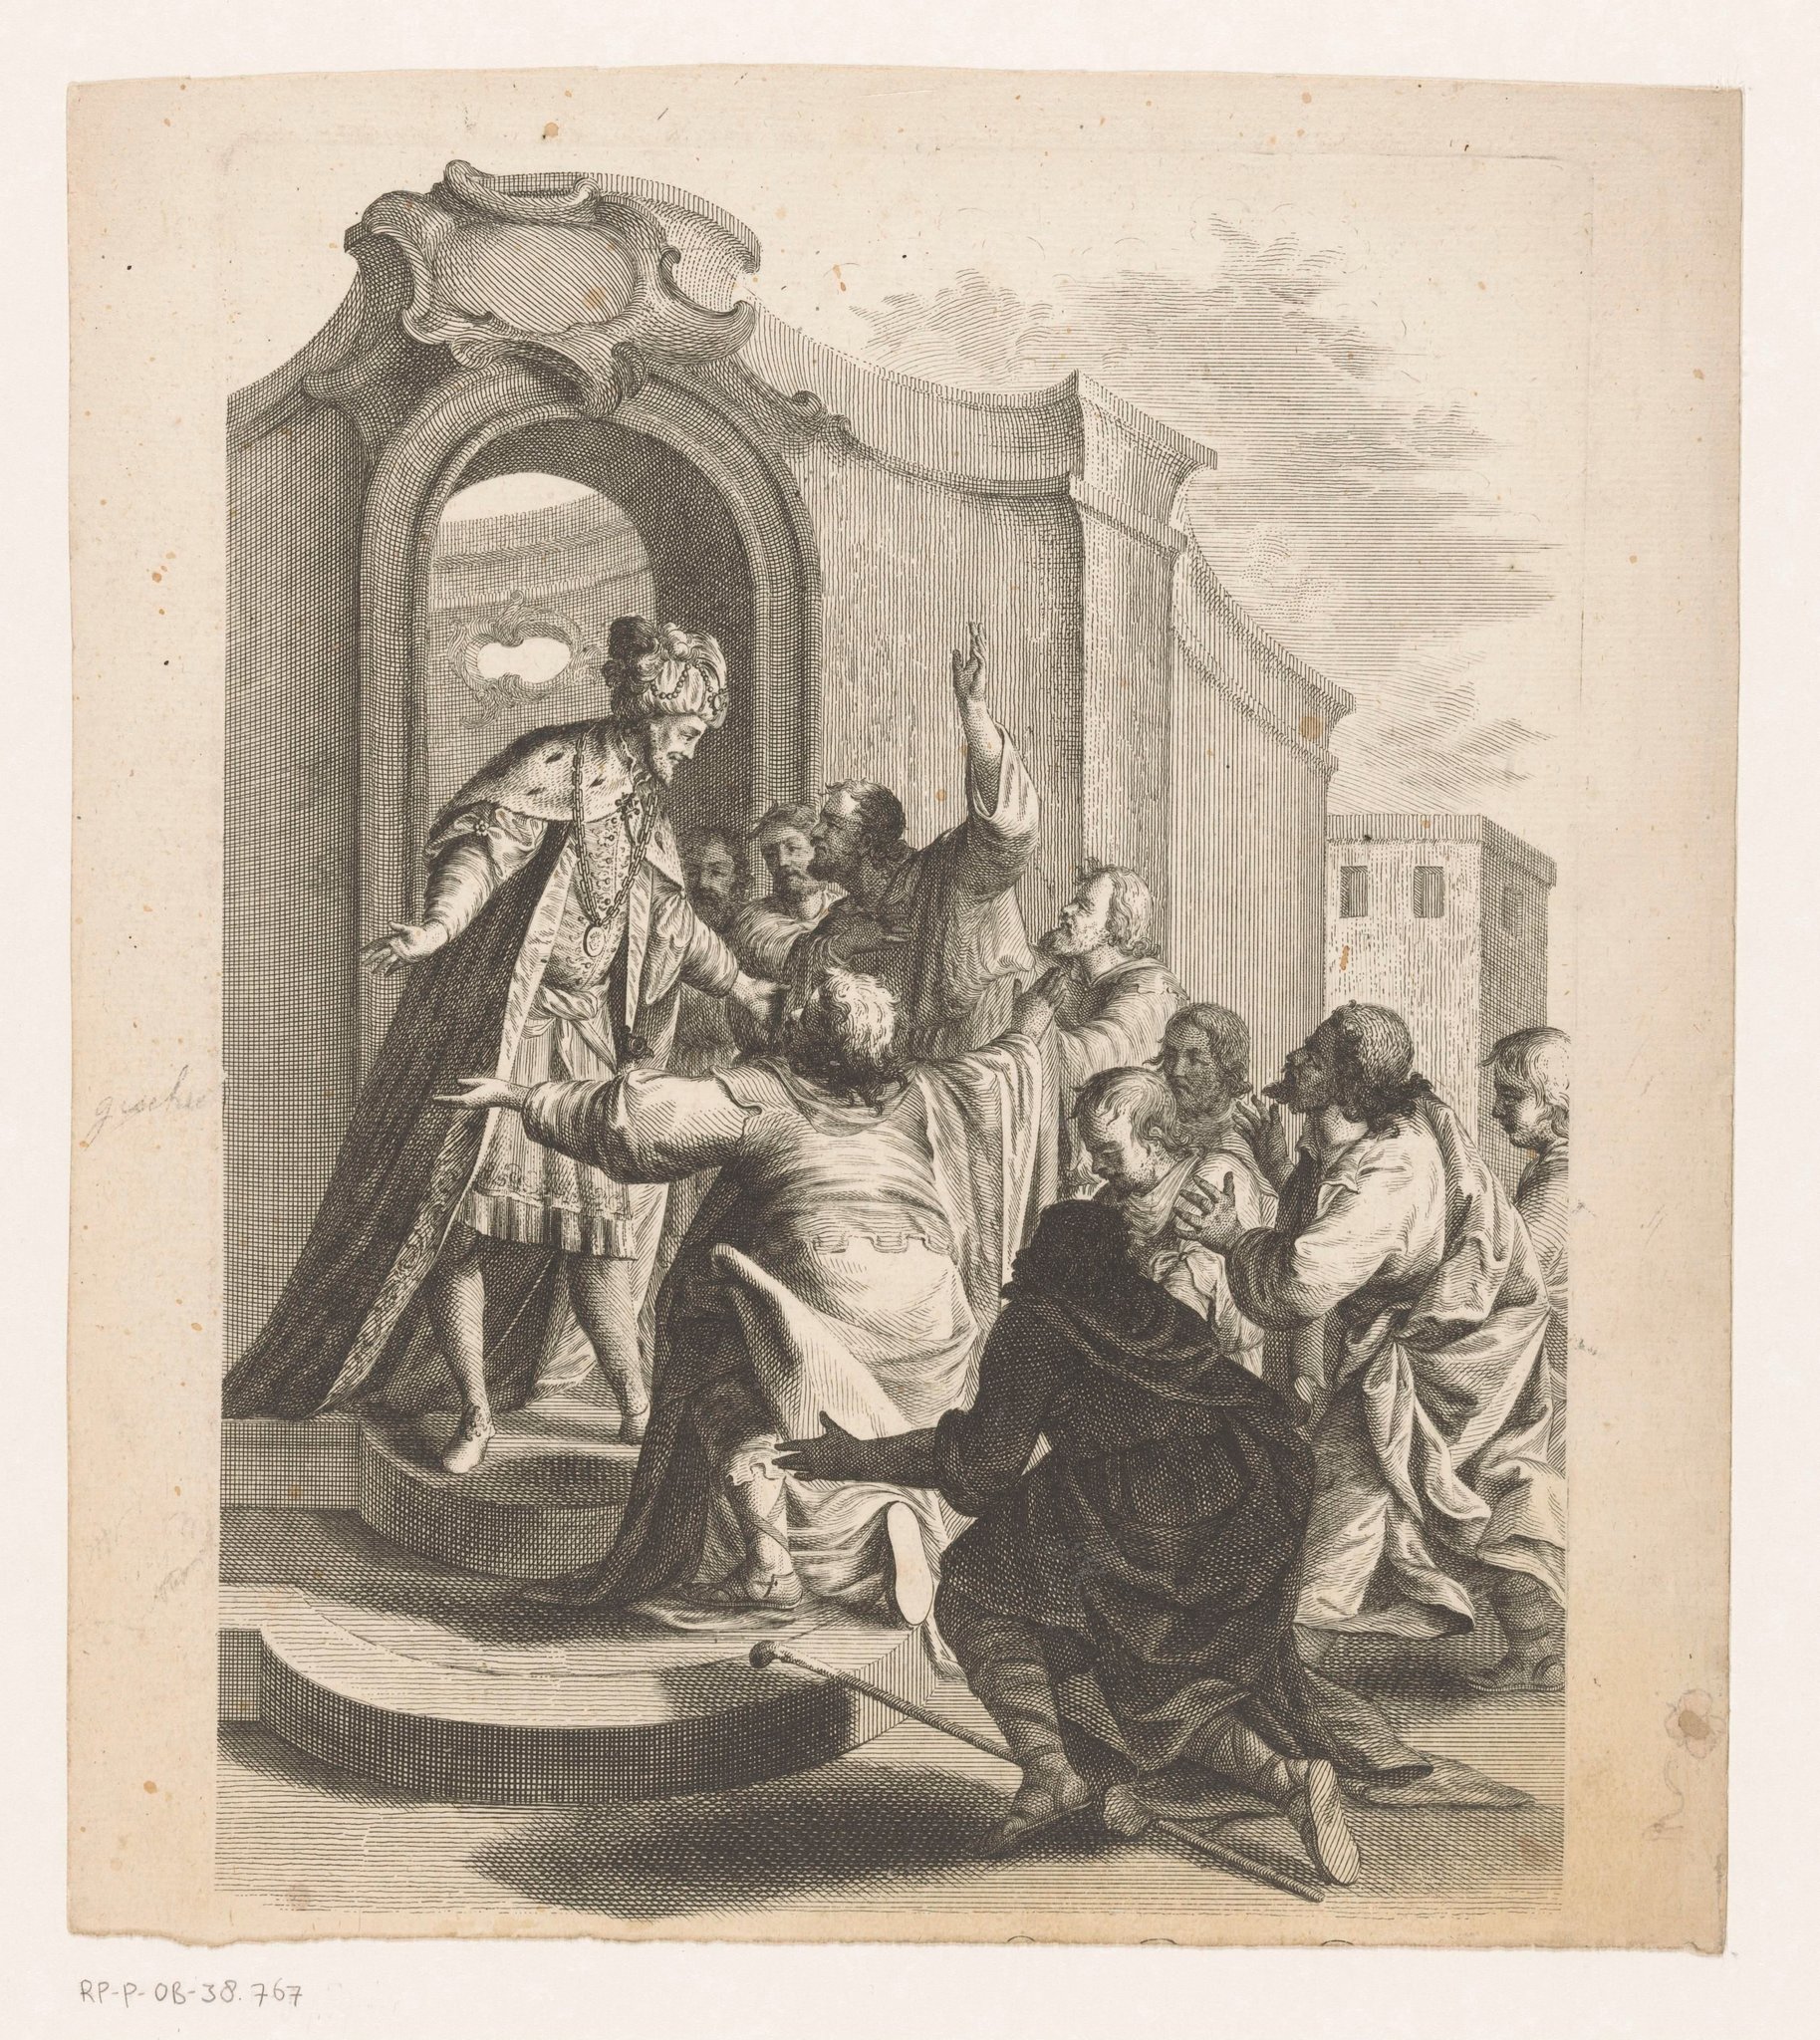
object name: print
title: Broers van Jozef knielen voor hem in Egypte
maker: Anonymous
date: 1600-1699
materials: paper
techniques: engraving, etching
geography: italy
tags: admitted in joseph's presence, the brothers bow down before him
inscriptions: collector's mark: Lugt 2228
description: Jozef staat voor de ingang van een paleis. Voor hem knielen zijn tien halfbroers die hem niet herkennen.